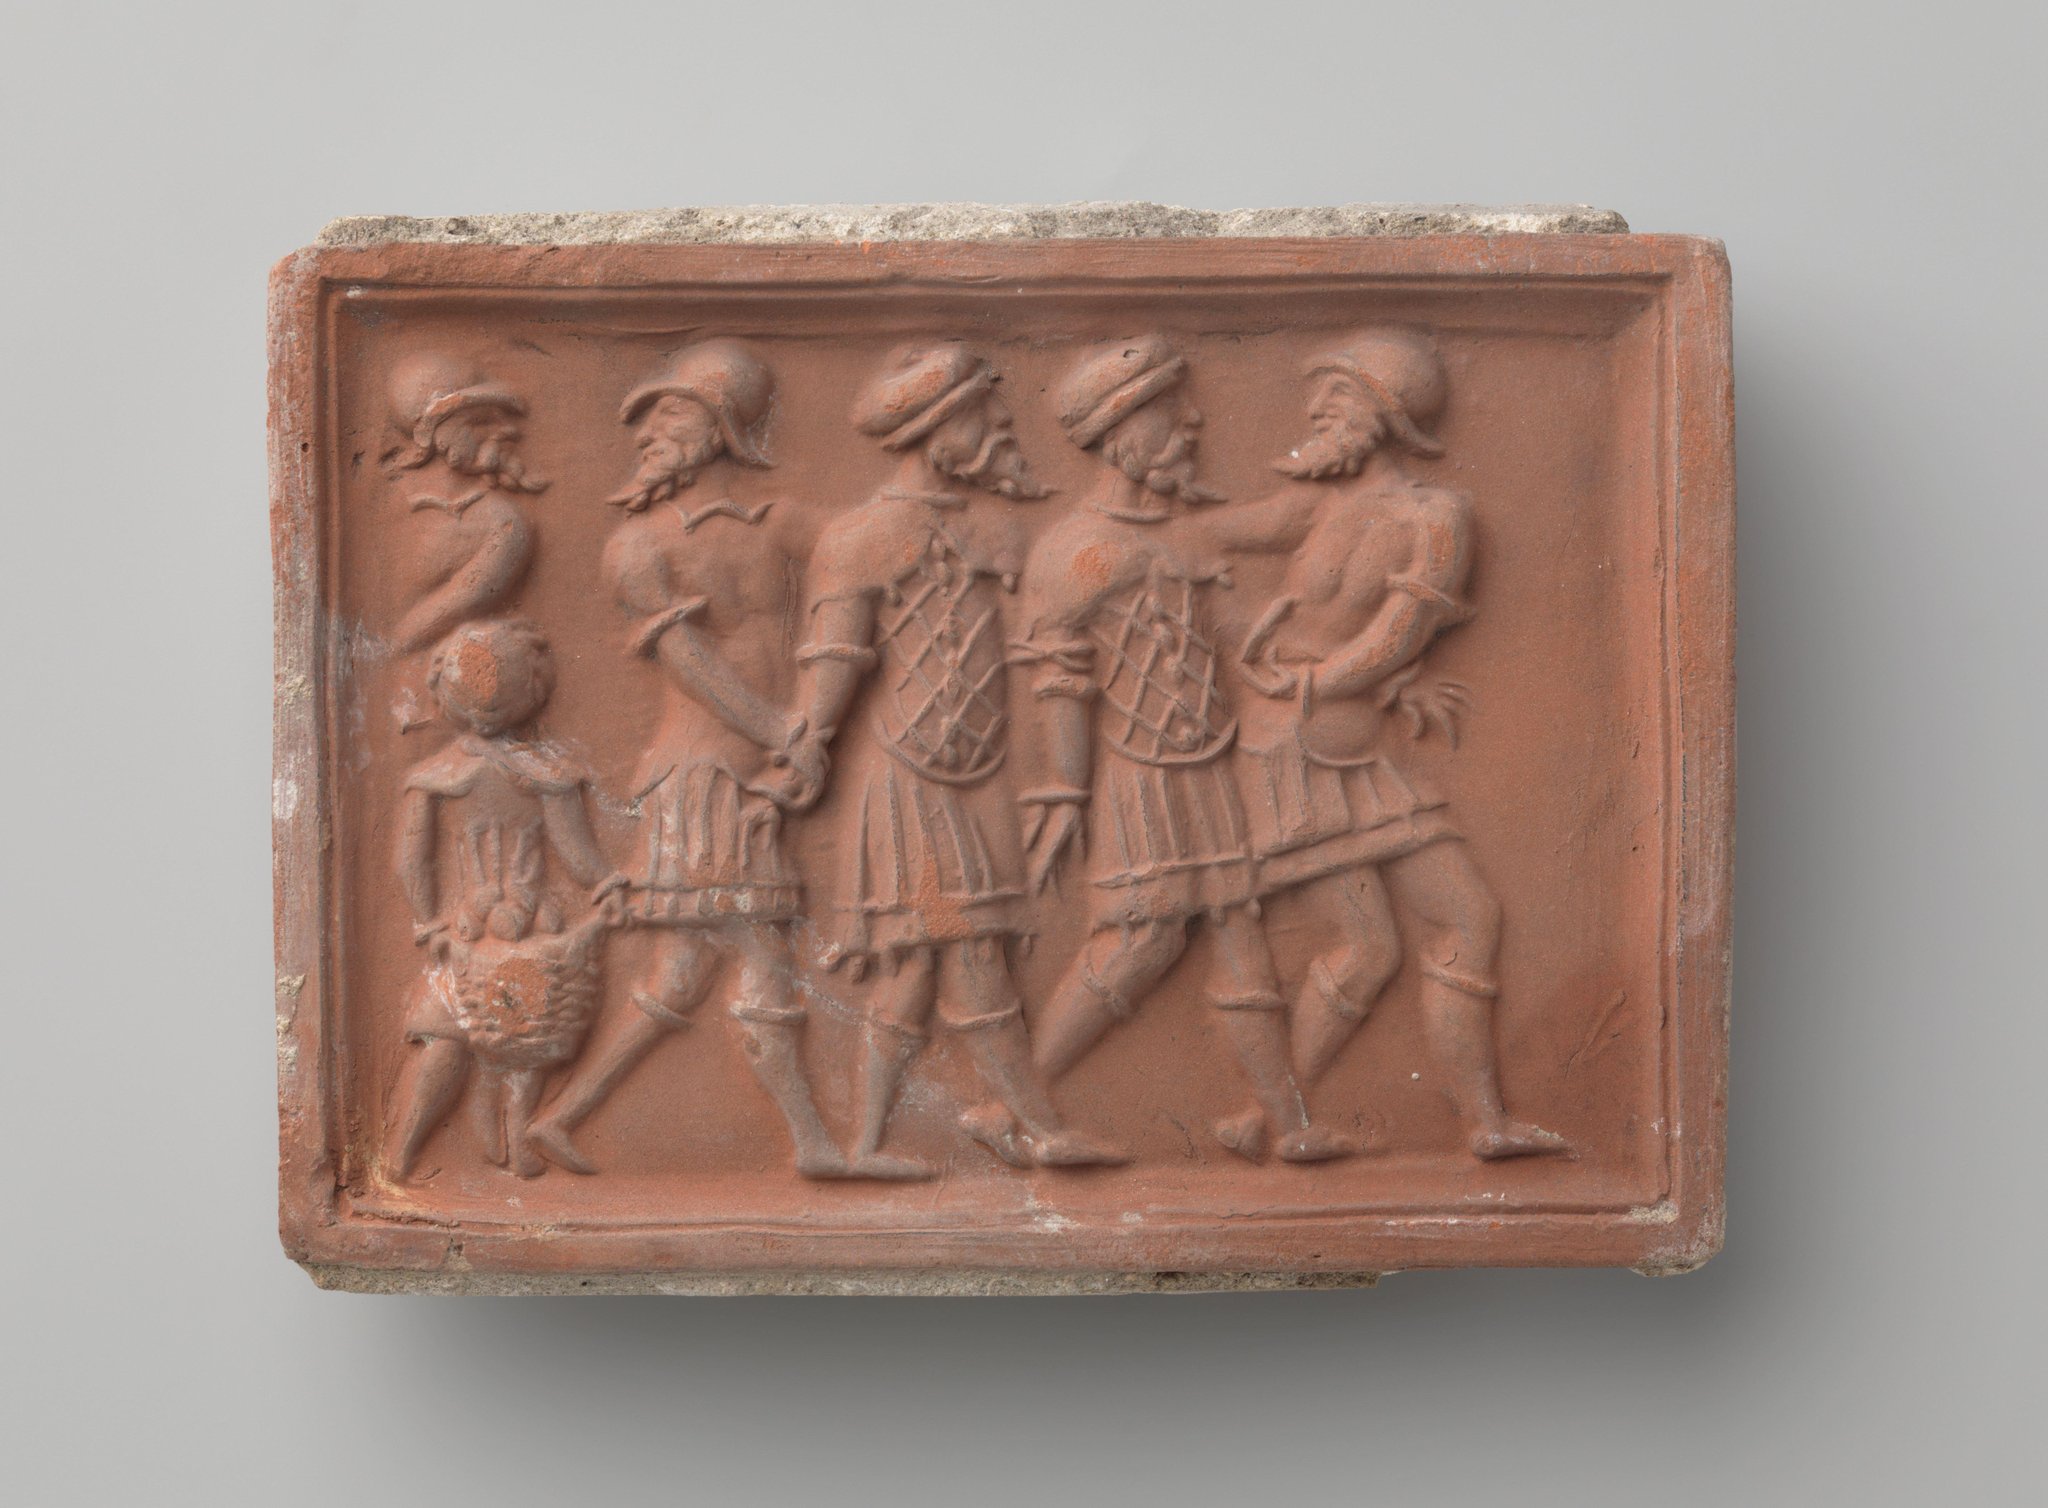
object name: hearthstone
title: Haardsteen met voorstelling van de beide ouderlingen uit de geschiedenis van Suzanna, die ter steniging worden weggeleid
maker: Anonymous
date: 1875-1900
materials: earthenware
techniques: printing, firing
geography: netherlands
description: Haardsteen met voorstelling van de beide ouderlingen uit de geschiedenis van Suzanna, die ter steniging worden weggeleid. Links draagt een jongen een mand met stenen aan.